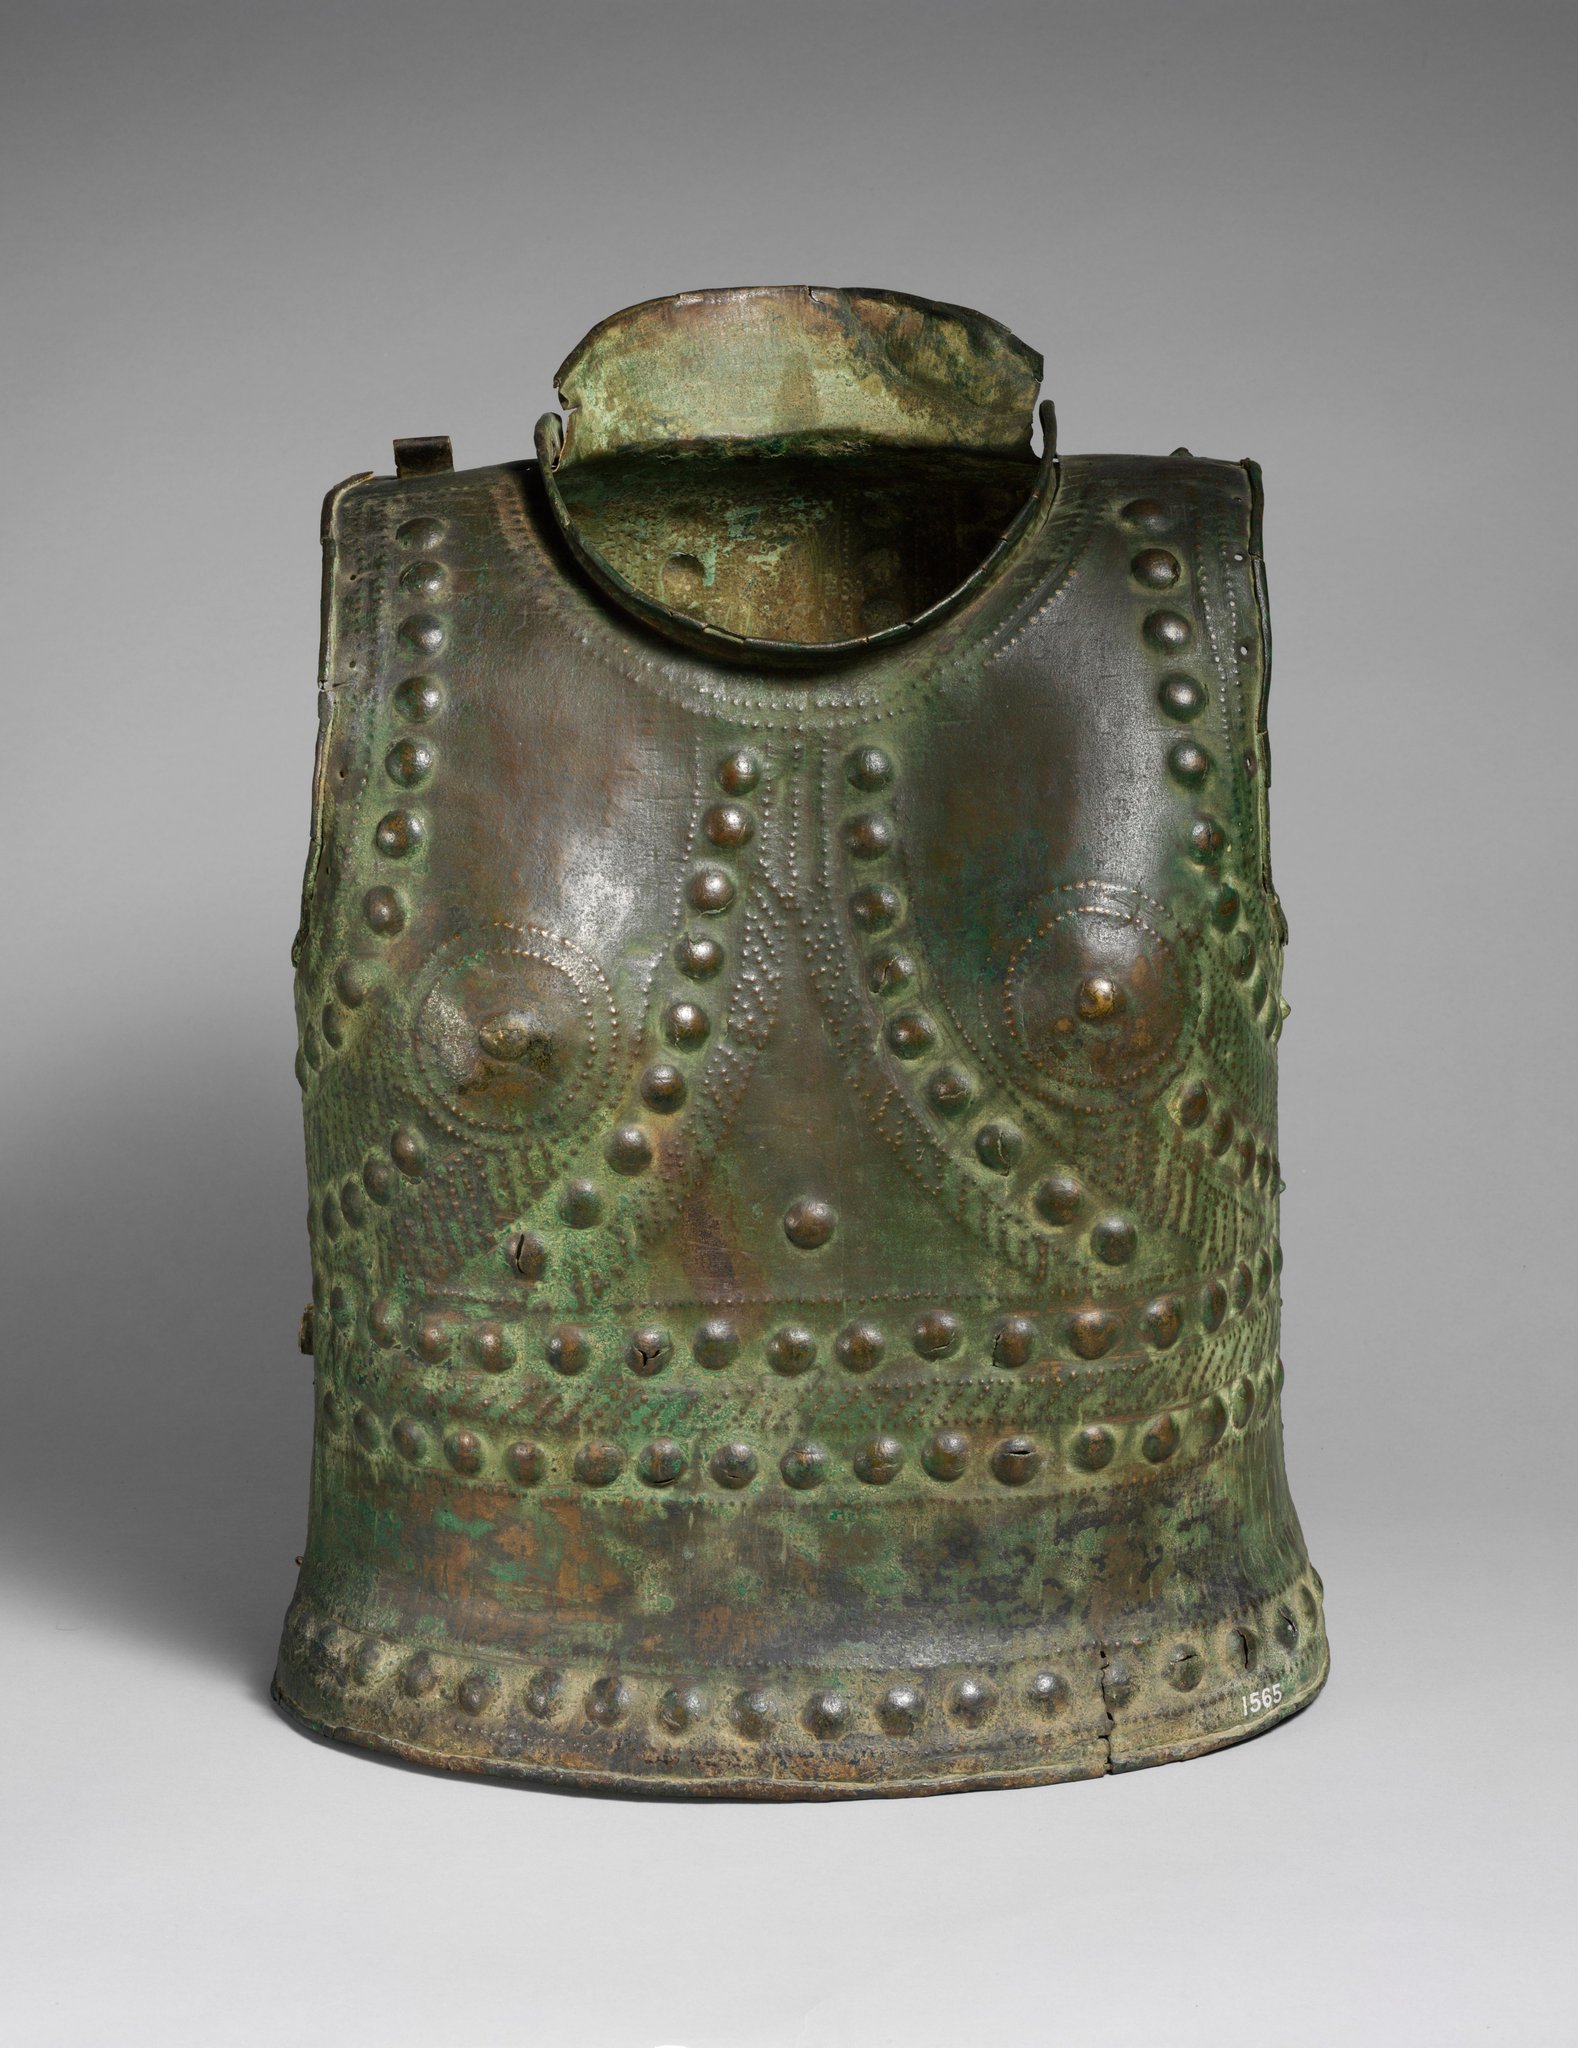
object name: cuirass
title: Bronze cuirass (breastplate)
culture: hallstatt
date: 1200-901 BCE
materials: bronze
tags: armor